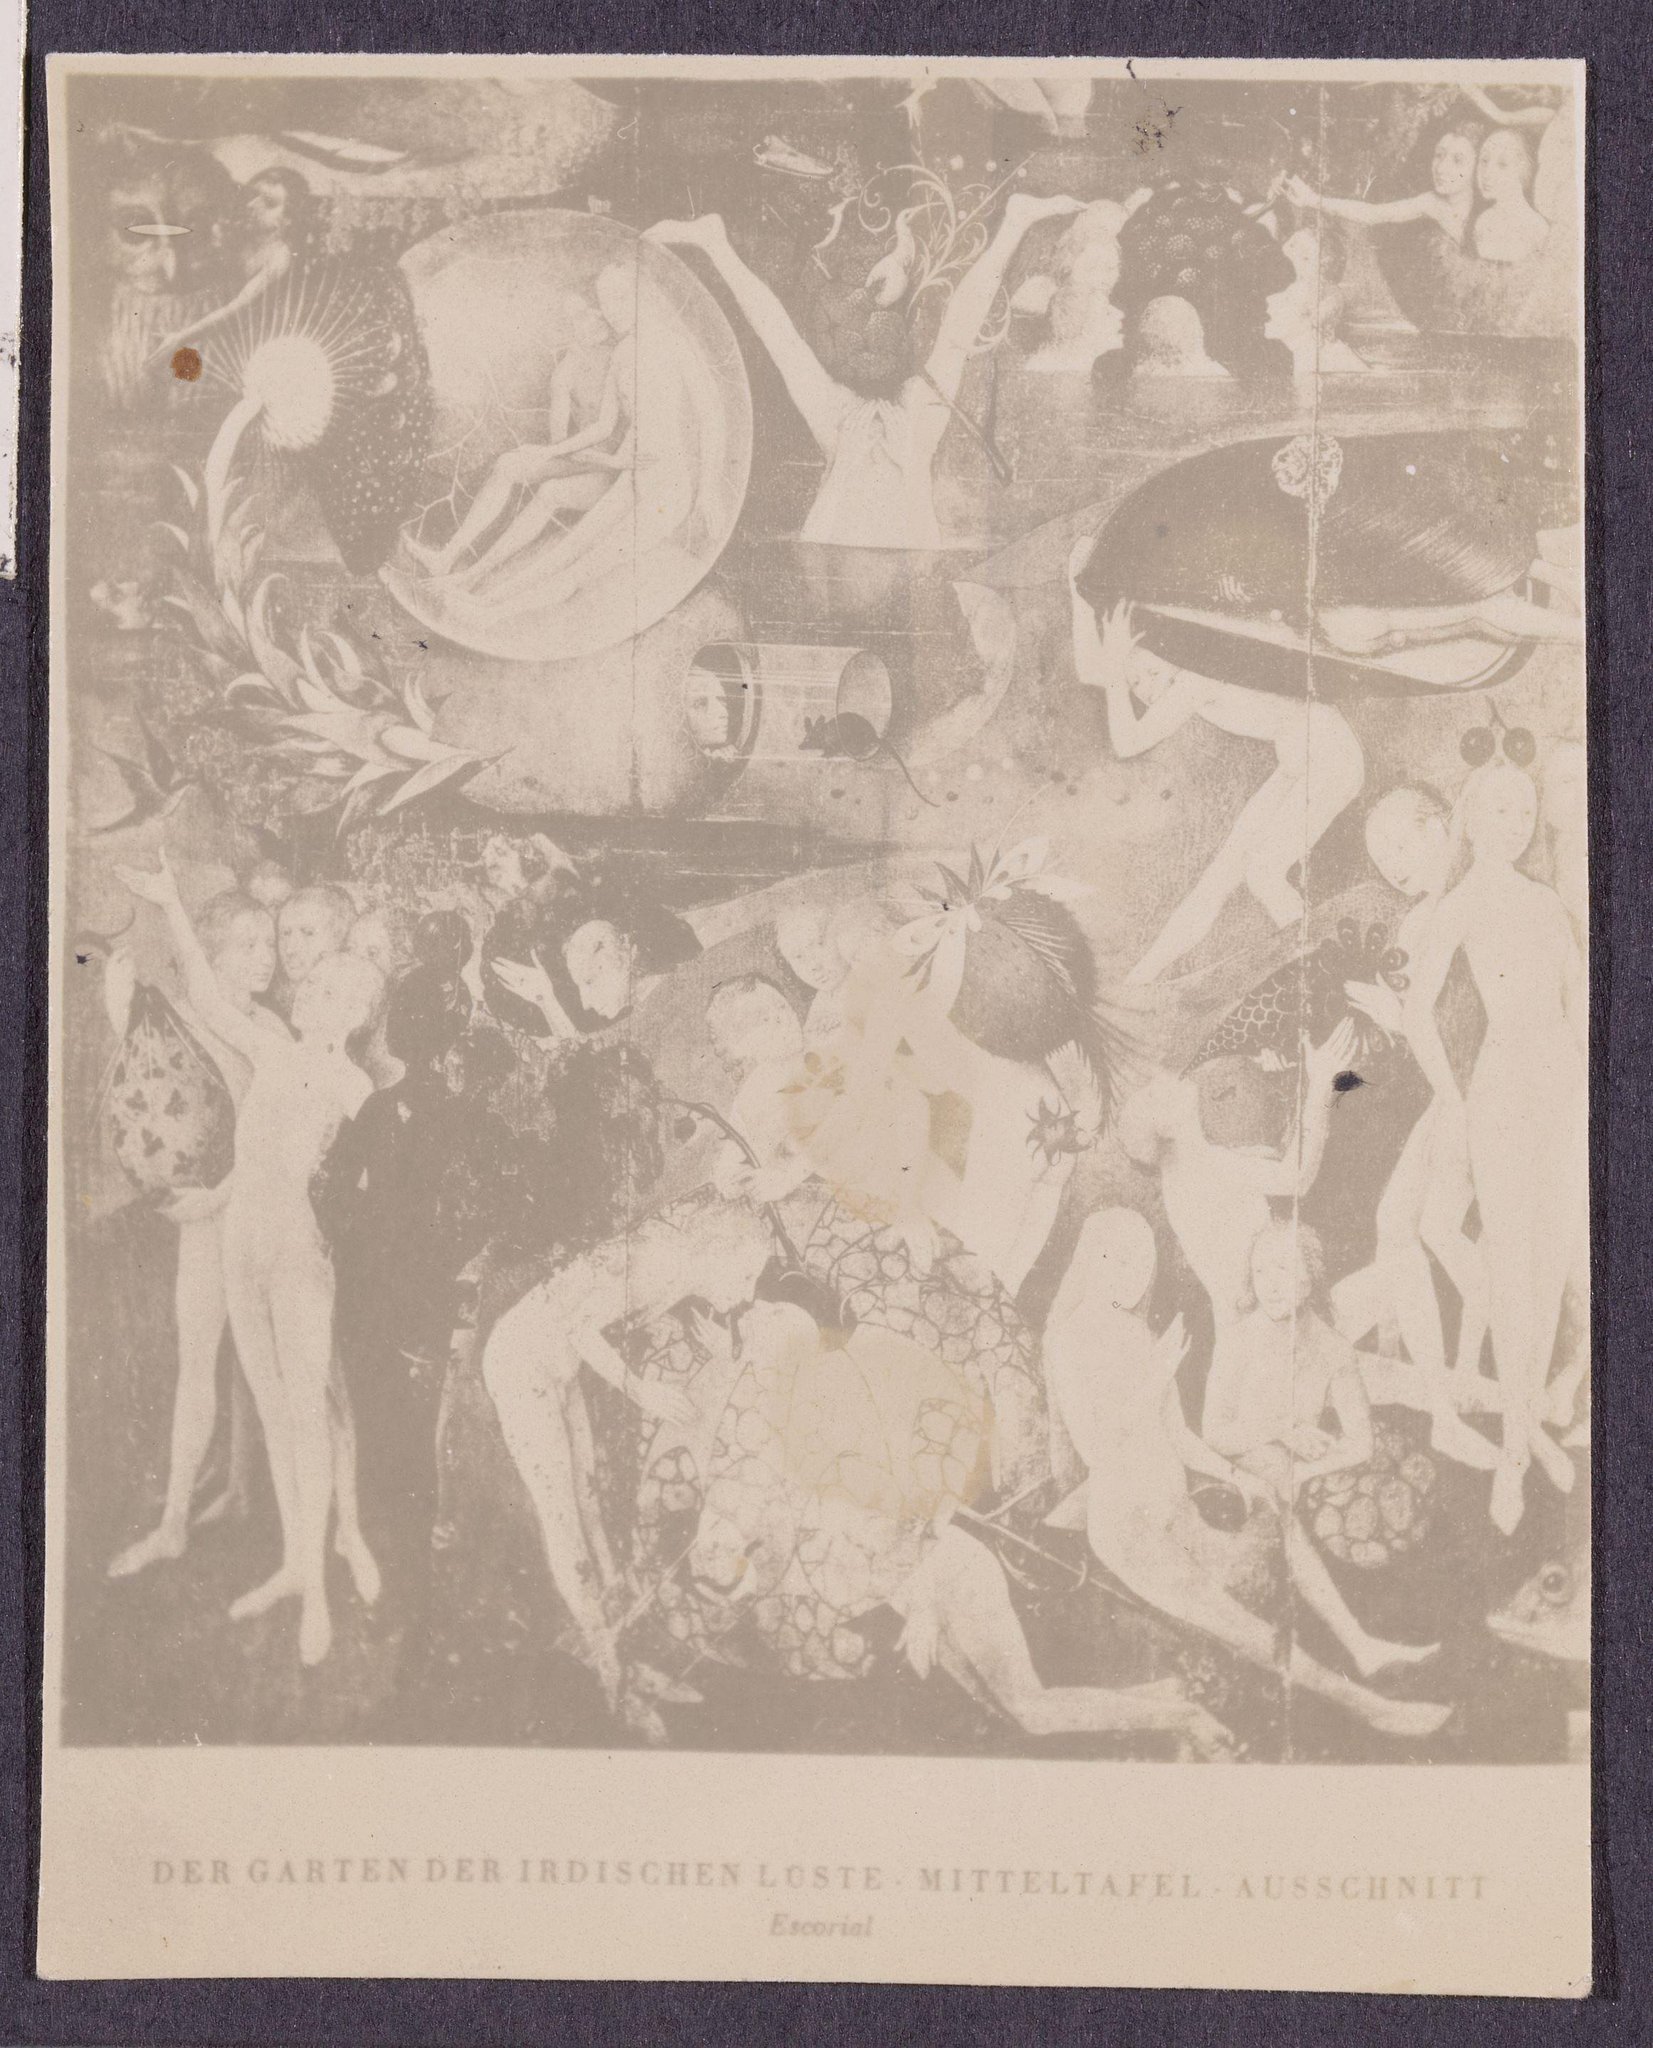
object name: photograph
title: Fotoreproductie van een schilderij van Jeroen Bosch uit het Escorial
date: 1930-1937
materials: cardboard, photographic support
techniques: gelatin silver print